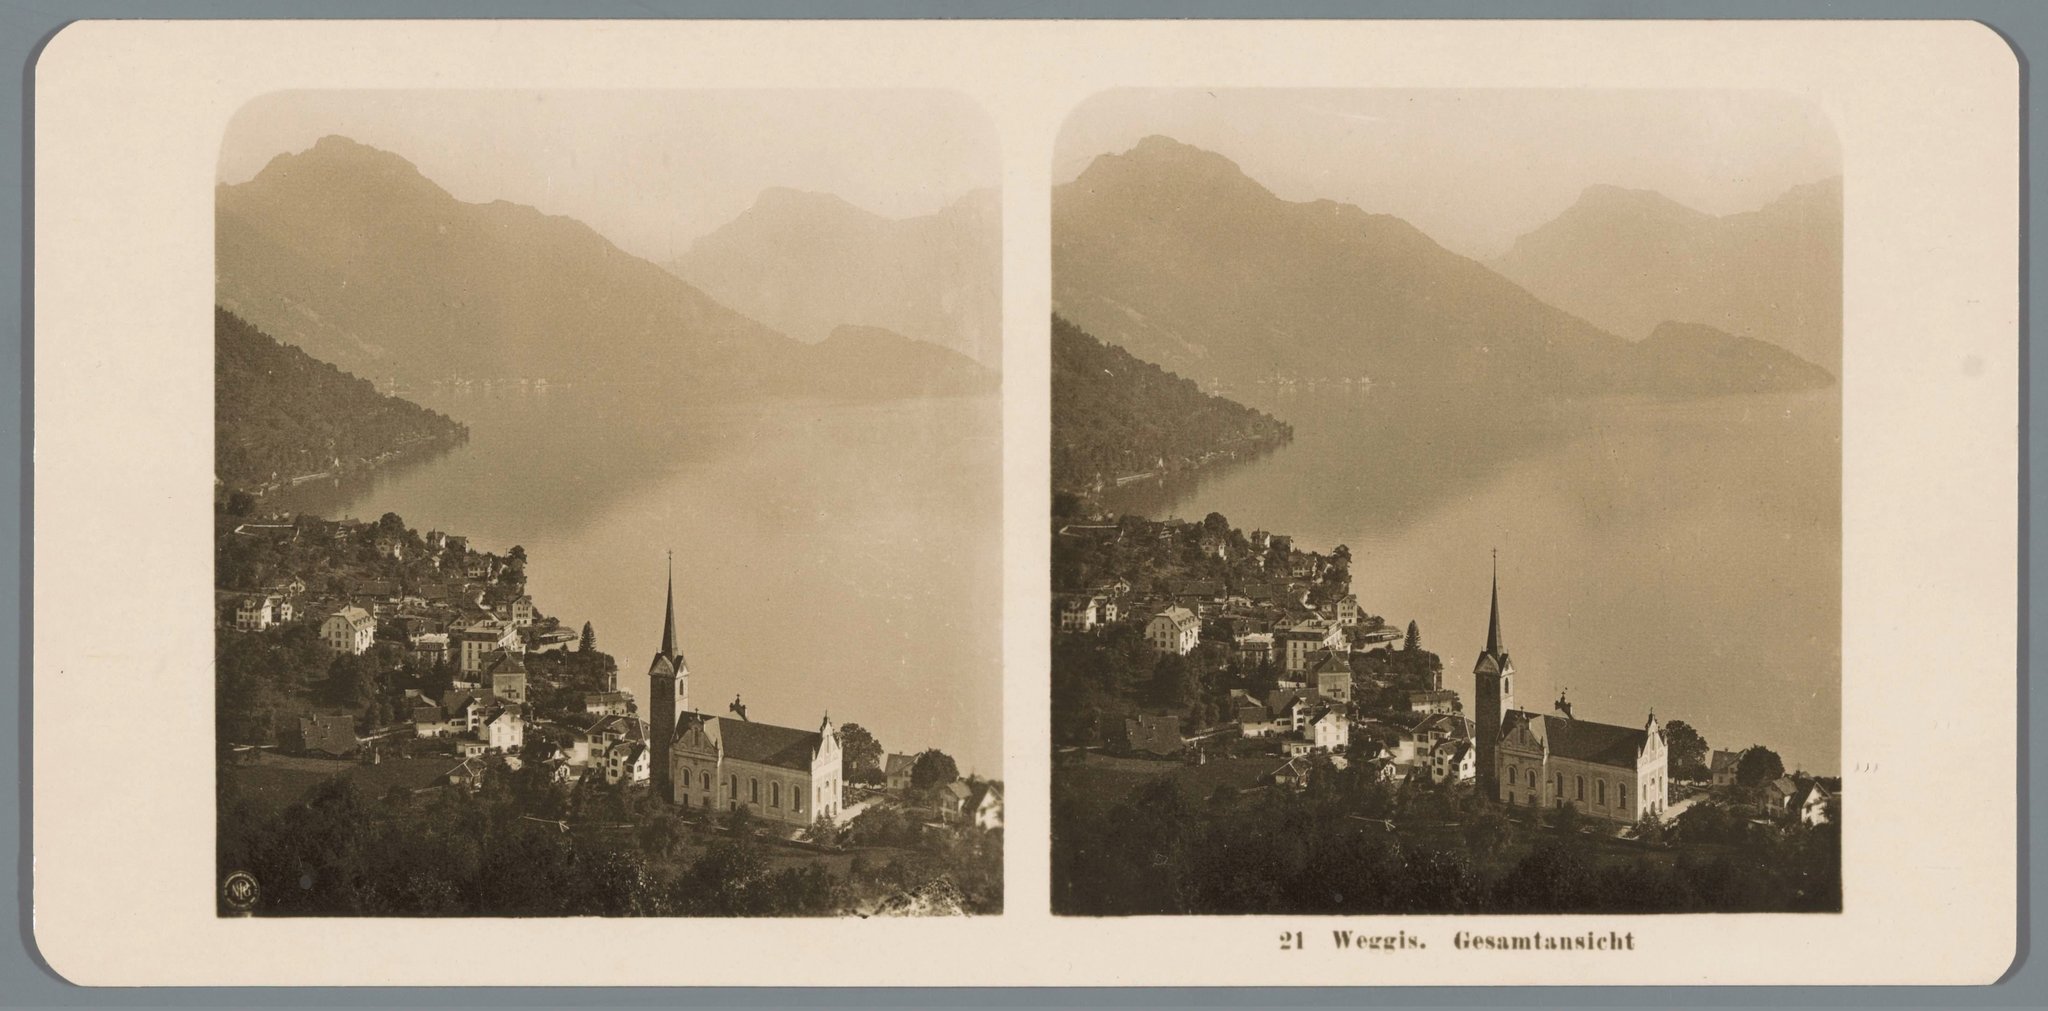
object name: stereograph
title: Gezicht op Weggis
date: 1900-1910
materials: cardboard, photographic support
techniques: gelatin silver print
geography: lucerne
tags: city-view in general; 'veduta', lake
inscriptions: number: ‘21’, inscription: ‘NPG’